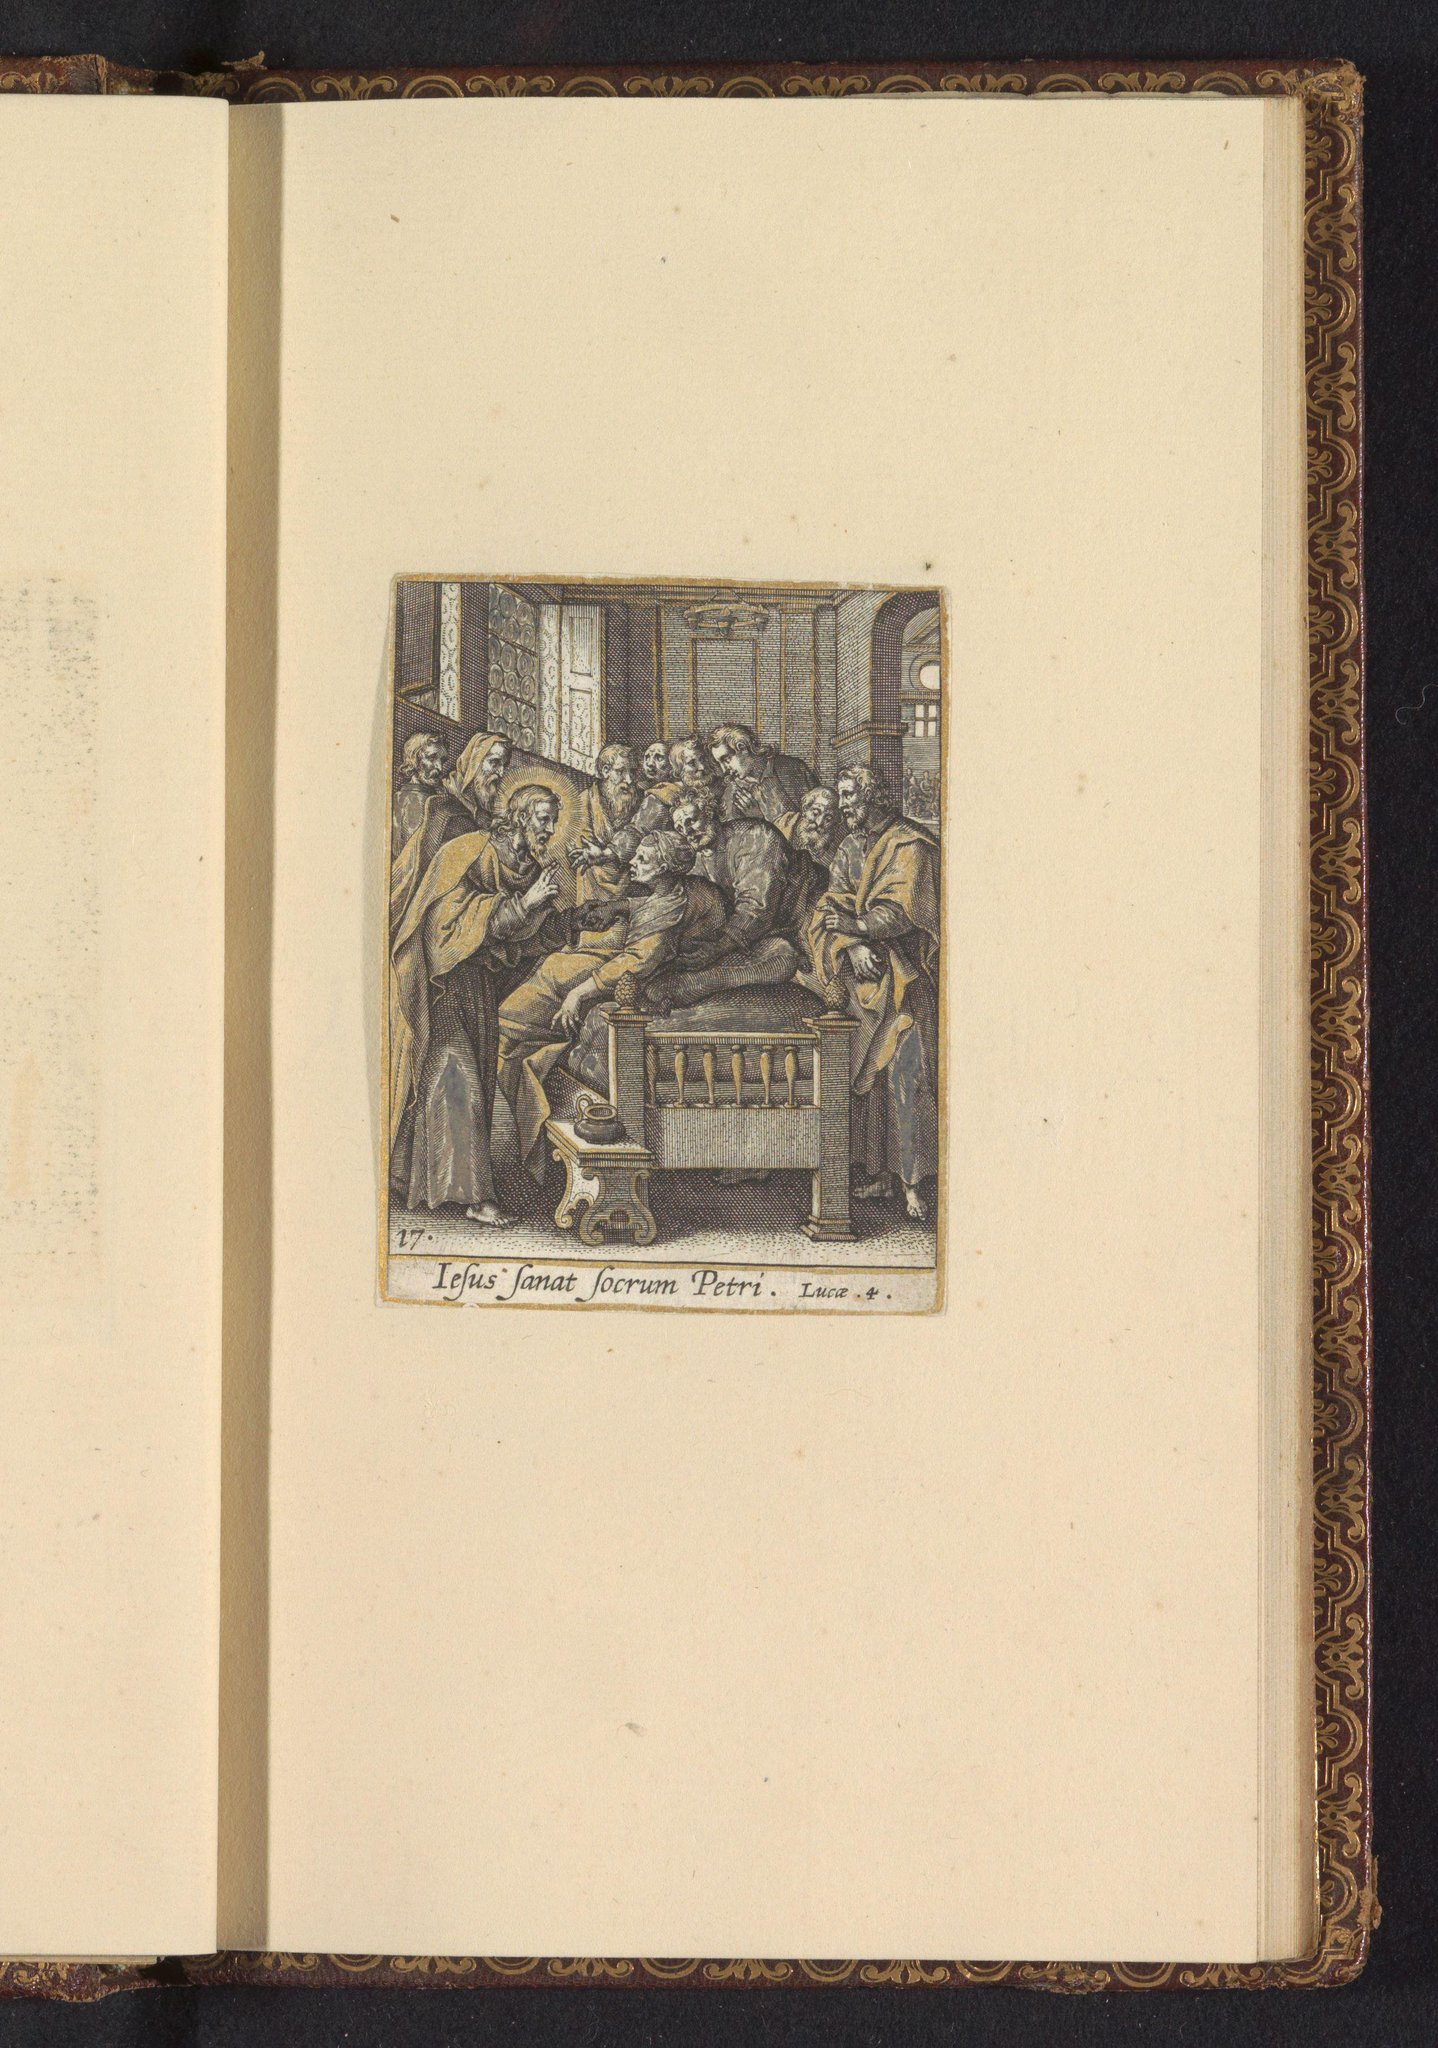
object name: print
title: Vita Iesu Salvatoris varijs iconibus ab Adriano Collaert expressa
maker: adriaen collaert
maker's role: draughtsman, print maker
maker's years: 1560-1618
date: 1580-1590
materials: gold, paper, silver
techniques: engraving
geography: antwerp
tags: healing of peter's mother-in-law (matthew 8:14-15; mark 1:29-31; luke 4:38-39)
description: Christus geneest de schoonmoeder van Petrus. Onderdeel van de prentserie over het leven van Christus: Vita Iesu Salvatoris varijs iconibus ab Adriano Collaert expressa. In prentalbum met twee reeksen van respectievelijk 34 en 25 gravures met scènes uit het leven en het lijdensverhaal van Christus.